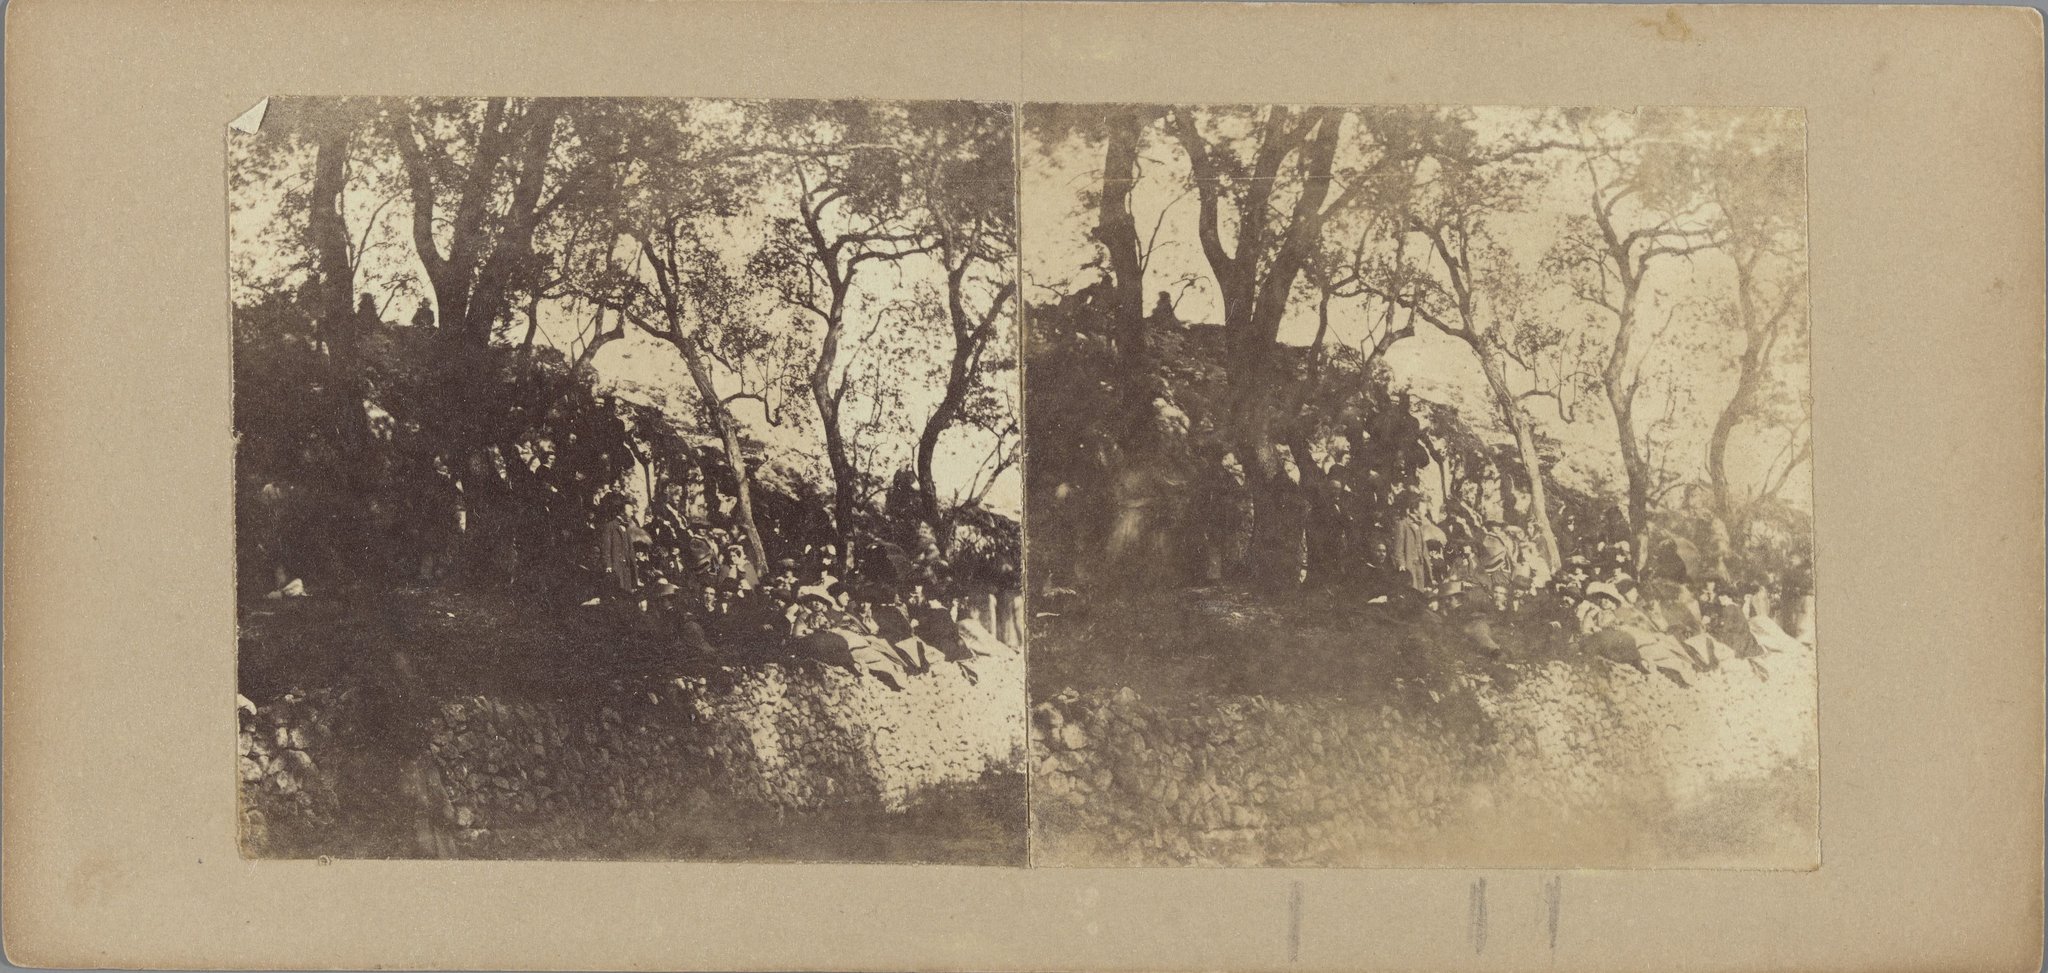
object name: stereograph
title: Groepsportret van deelnemers aan een picknick onder de bomen bij Falicon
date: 1859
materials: paper, photographic support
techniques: albumen print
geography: falicon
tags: eating and drinking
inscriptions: inscription: ‘Pic-nic party at Falicon Nice, 28th July 1859 (...)’